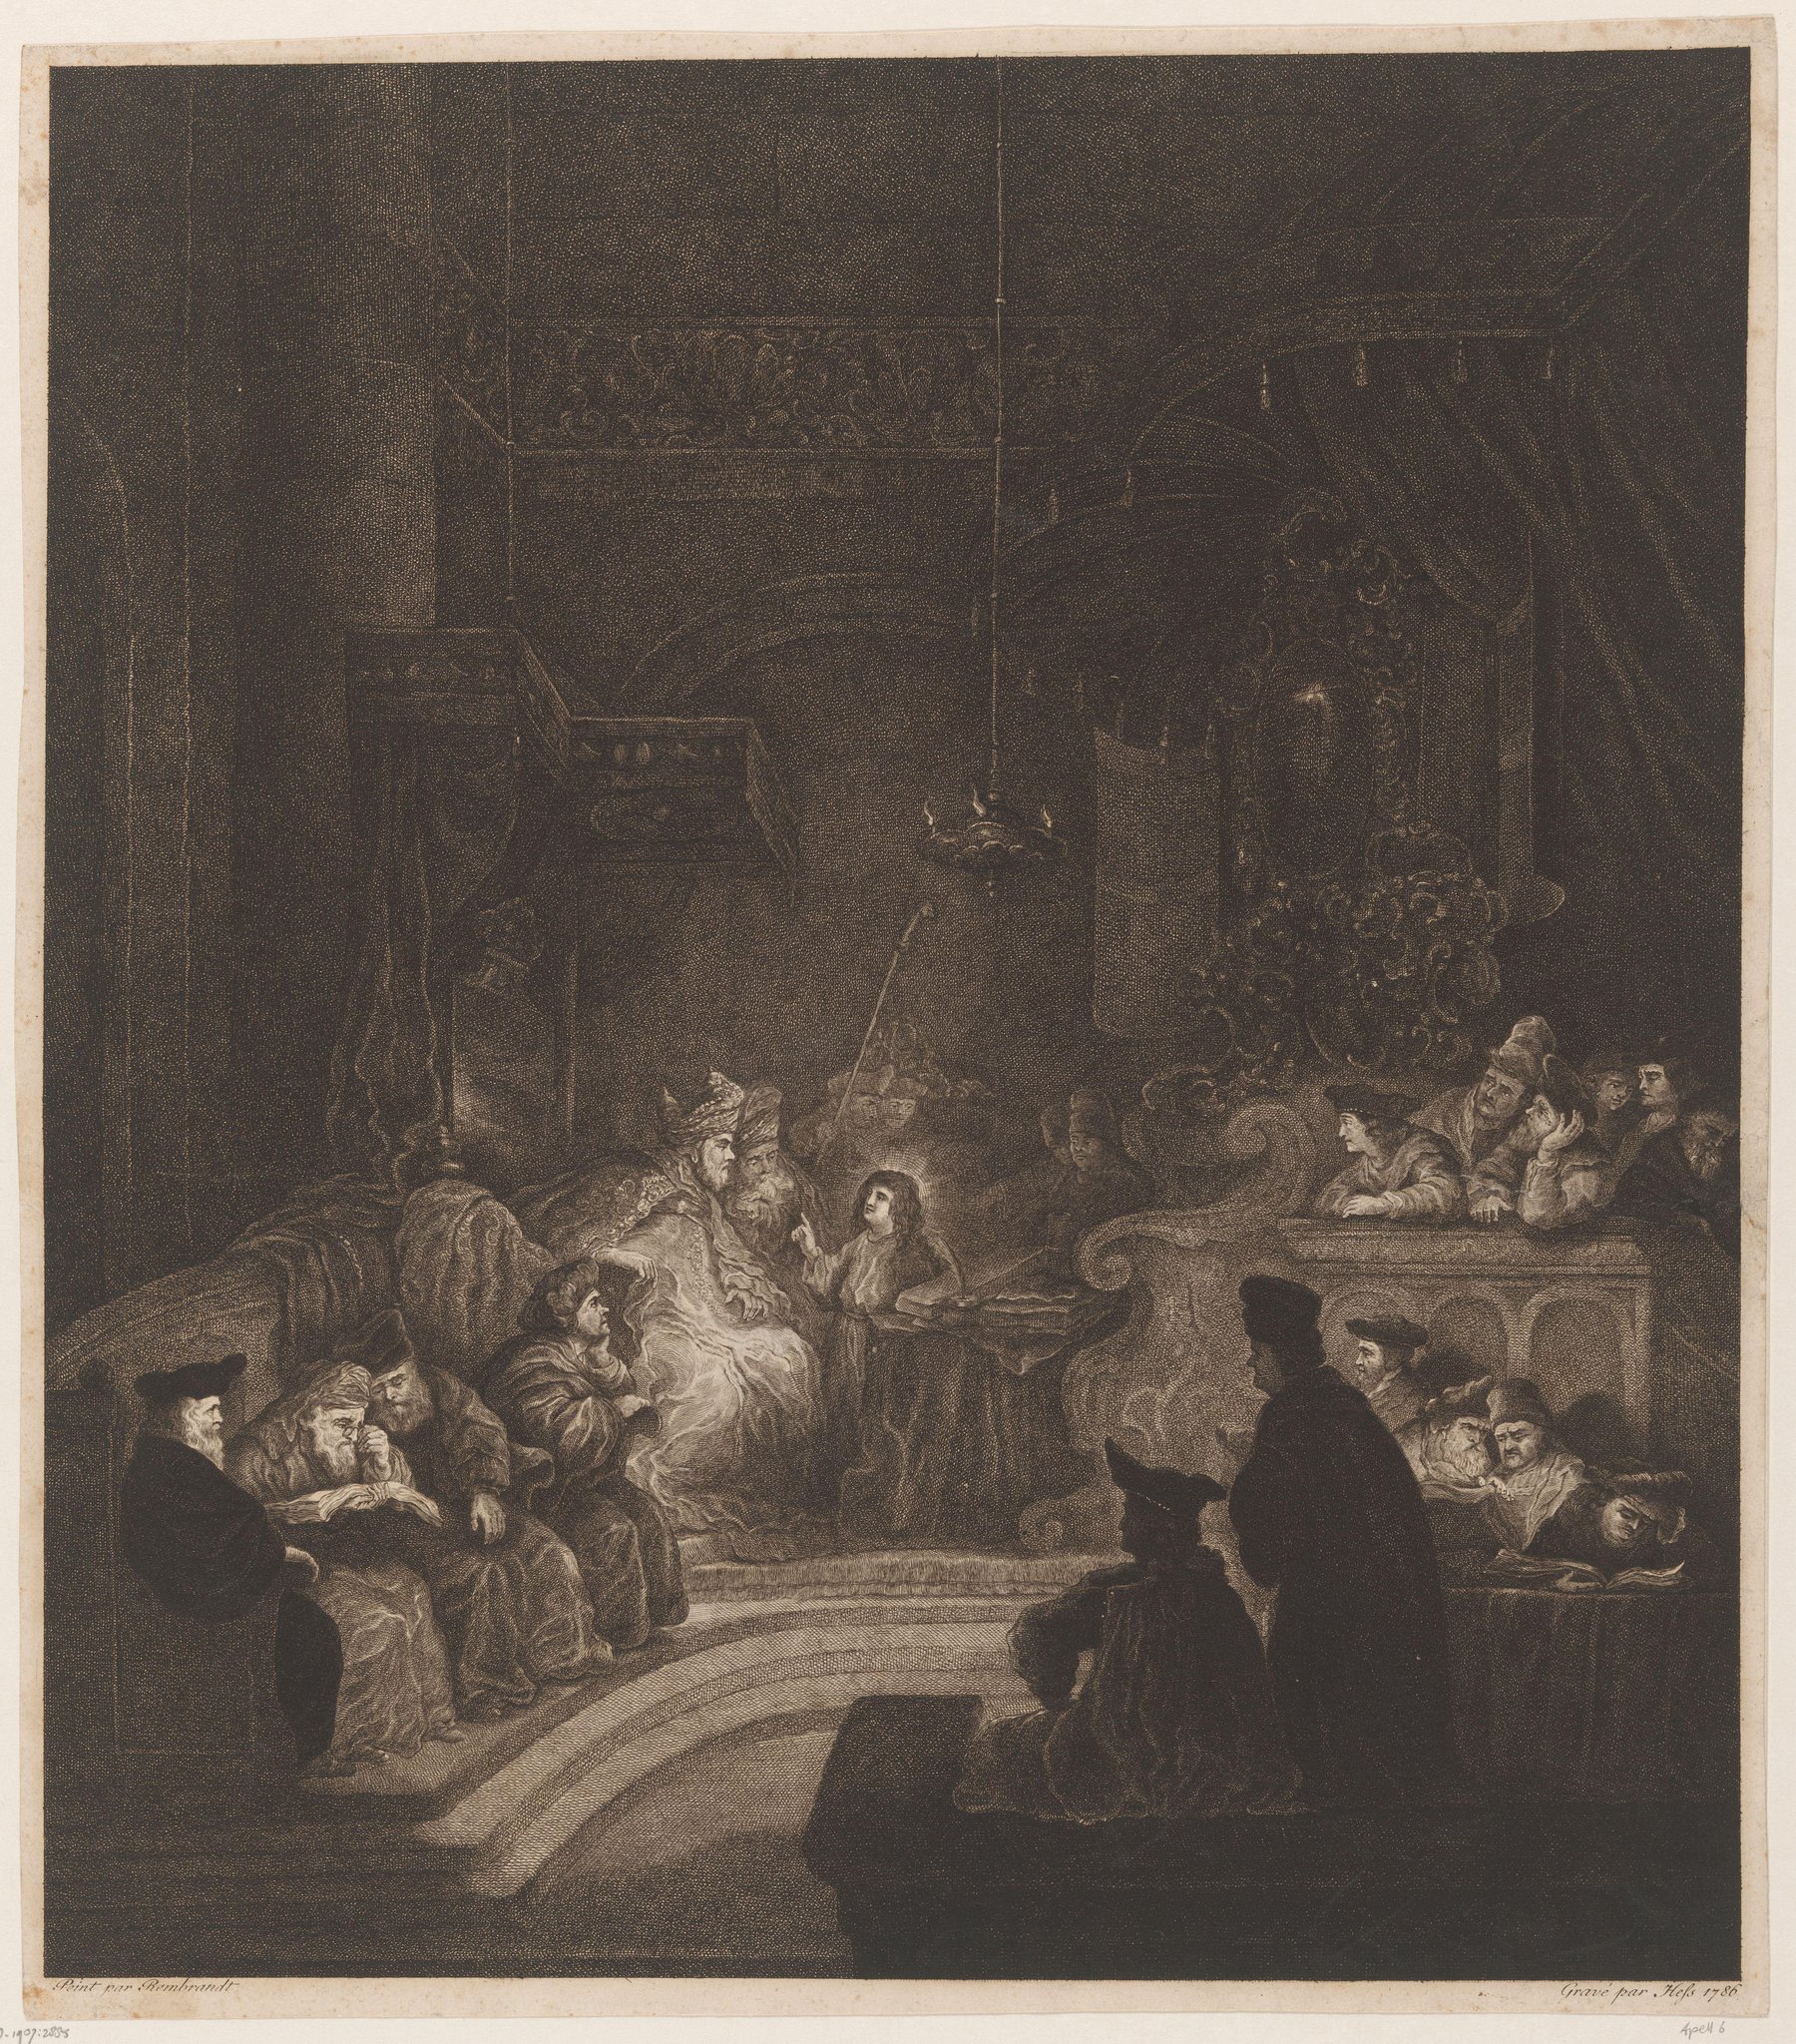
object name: print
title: Christus predikend in de tempel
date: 1786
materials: paper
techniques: etching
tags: christ preaching in the temple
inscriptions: collector's mark: Lugt 2228